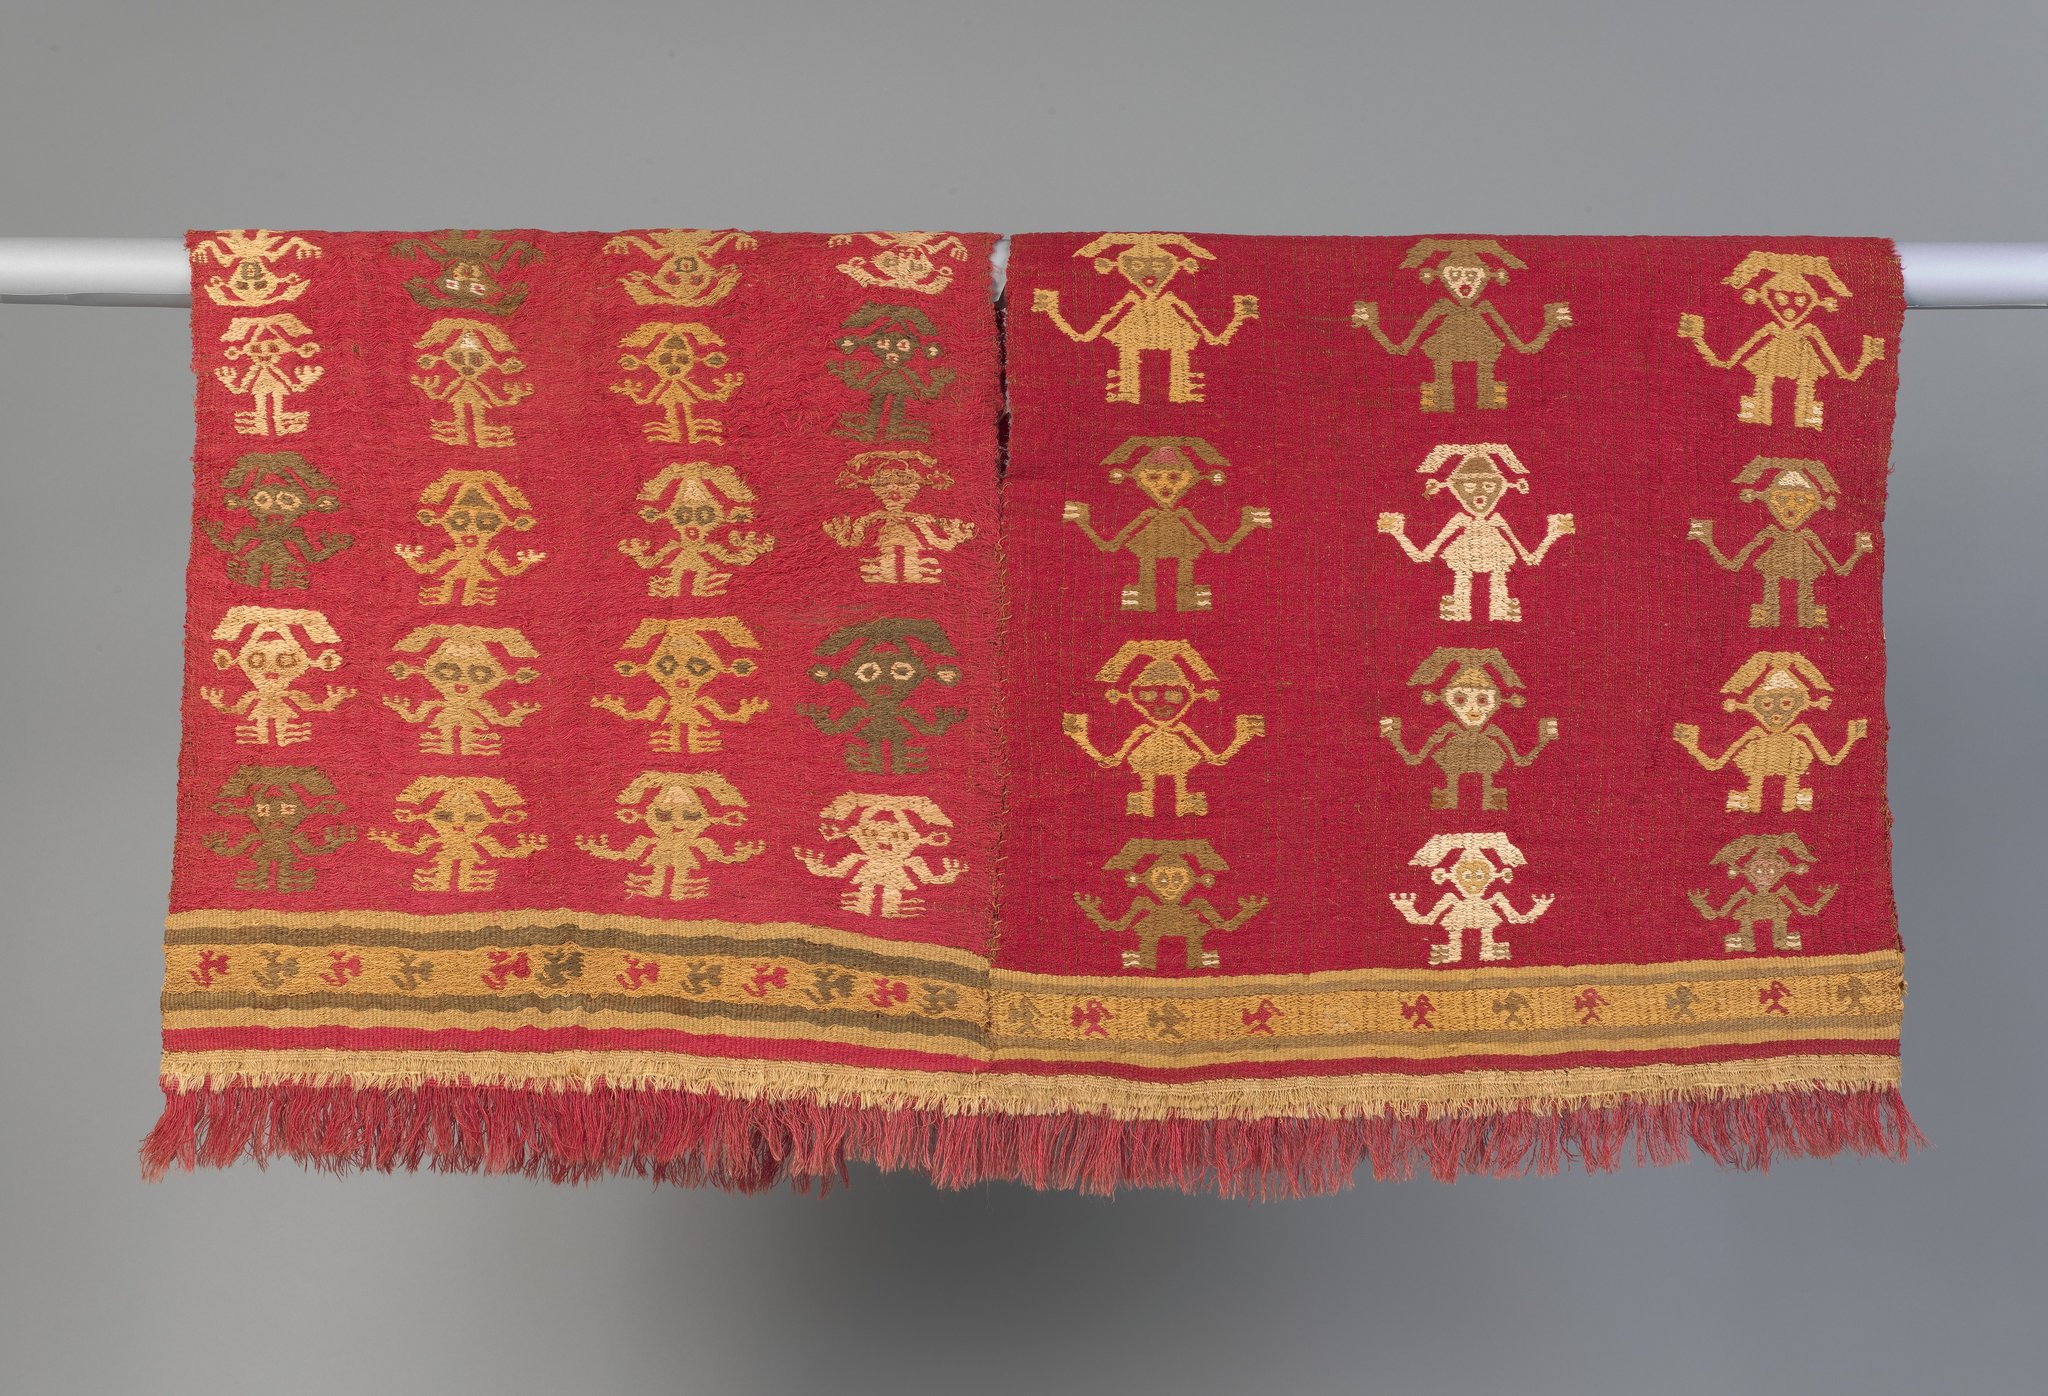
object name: tunic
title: Tunic with Crescent Headdress Figures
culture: chimú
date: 1460-1540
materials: animal fiber, cotton, wool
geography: peru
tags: human figures